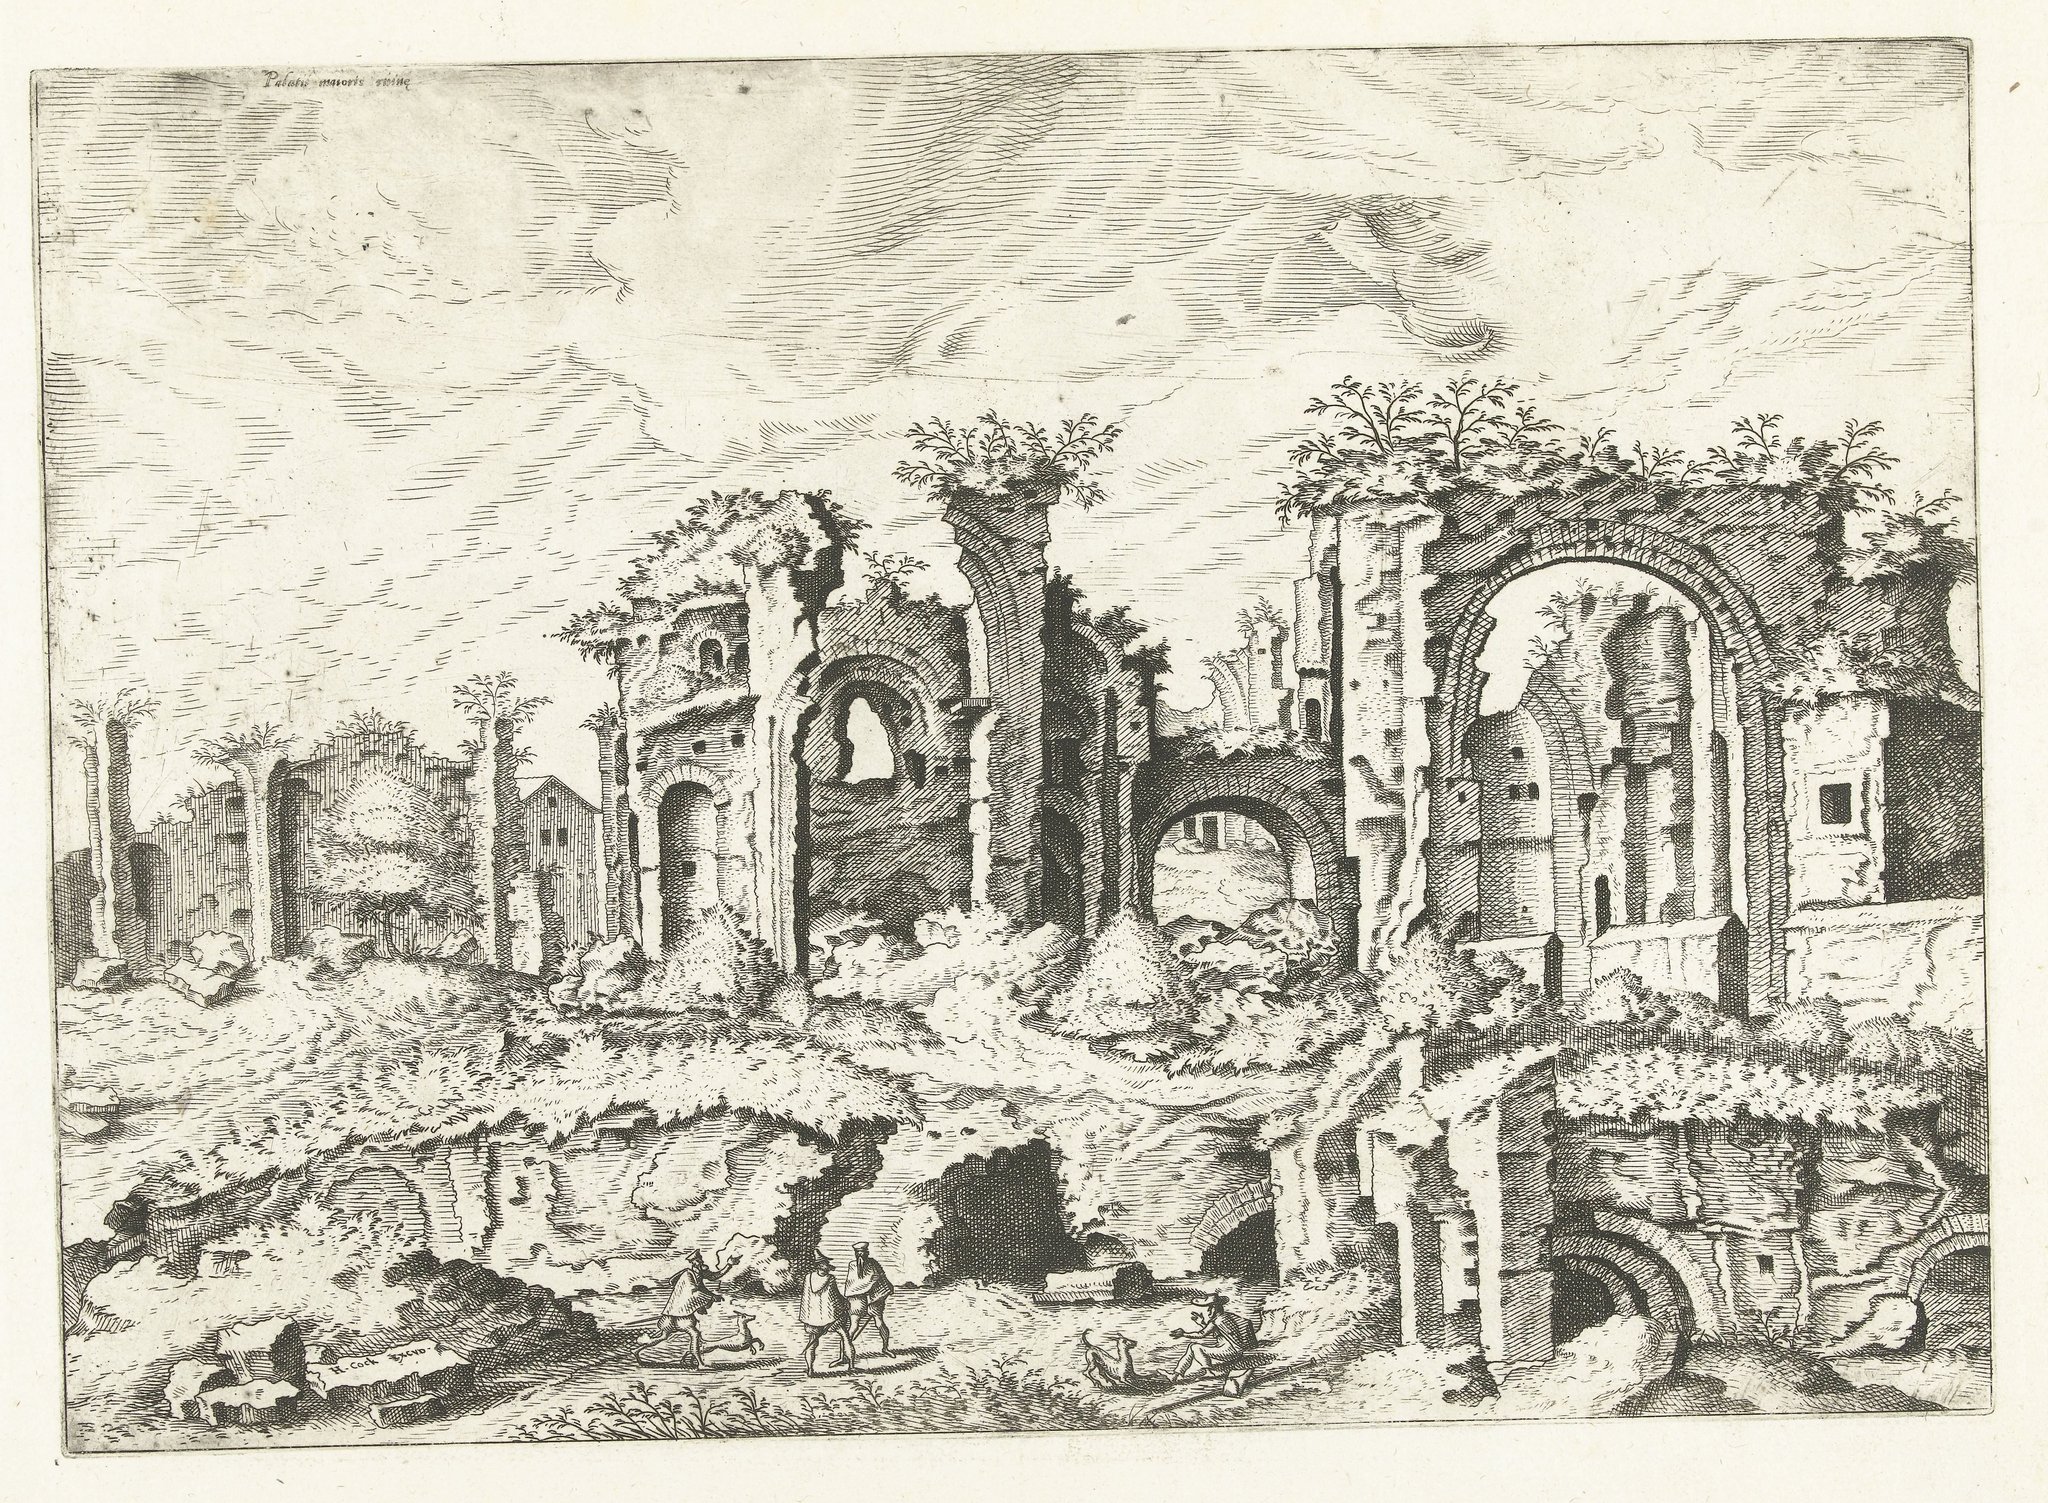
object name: print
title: Vierde gezicht op ruïnes op de Palatijn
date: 1561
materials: paper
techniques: engraving, etching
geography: antwerp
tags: landscape with ruins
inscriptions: watermark: Briquet 9320-30, collector's mark: Lugt 2228, collector's mark: Lugt 2760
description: Vierde gezicht op de ruïnes op de Palatijn in Rome. Tussen de ruïnes spelen twee mannen met hun honden.